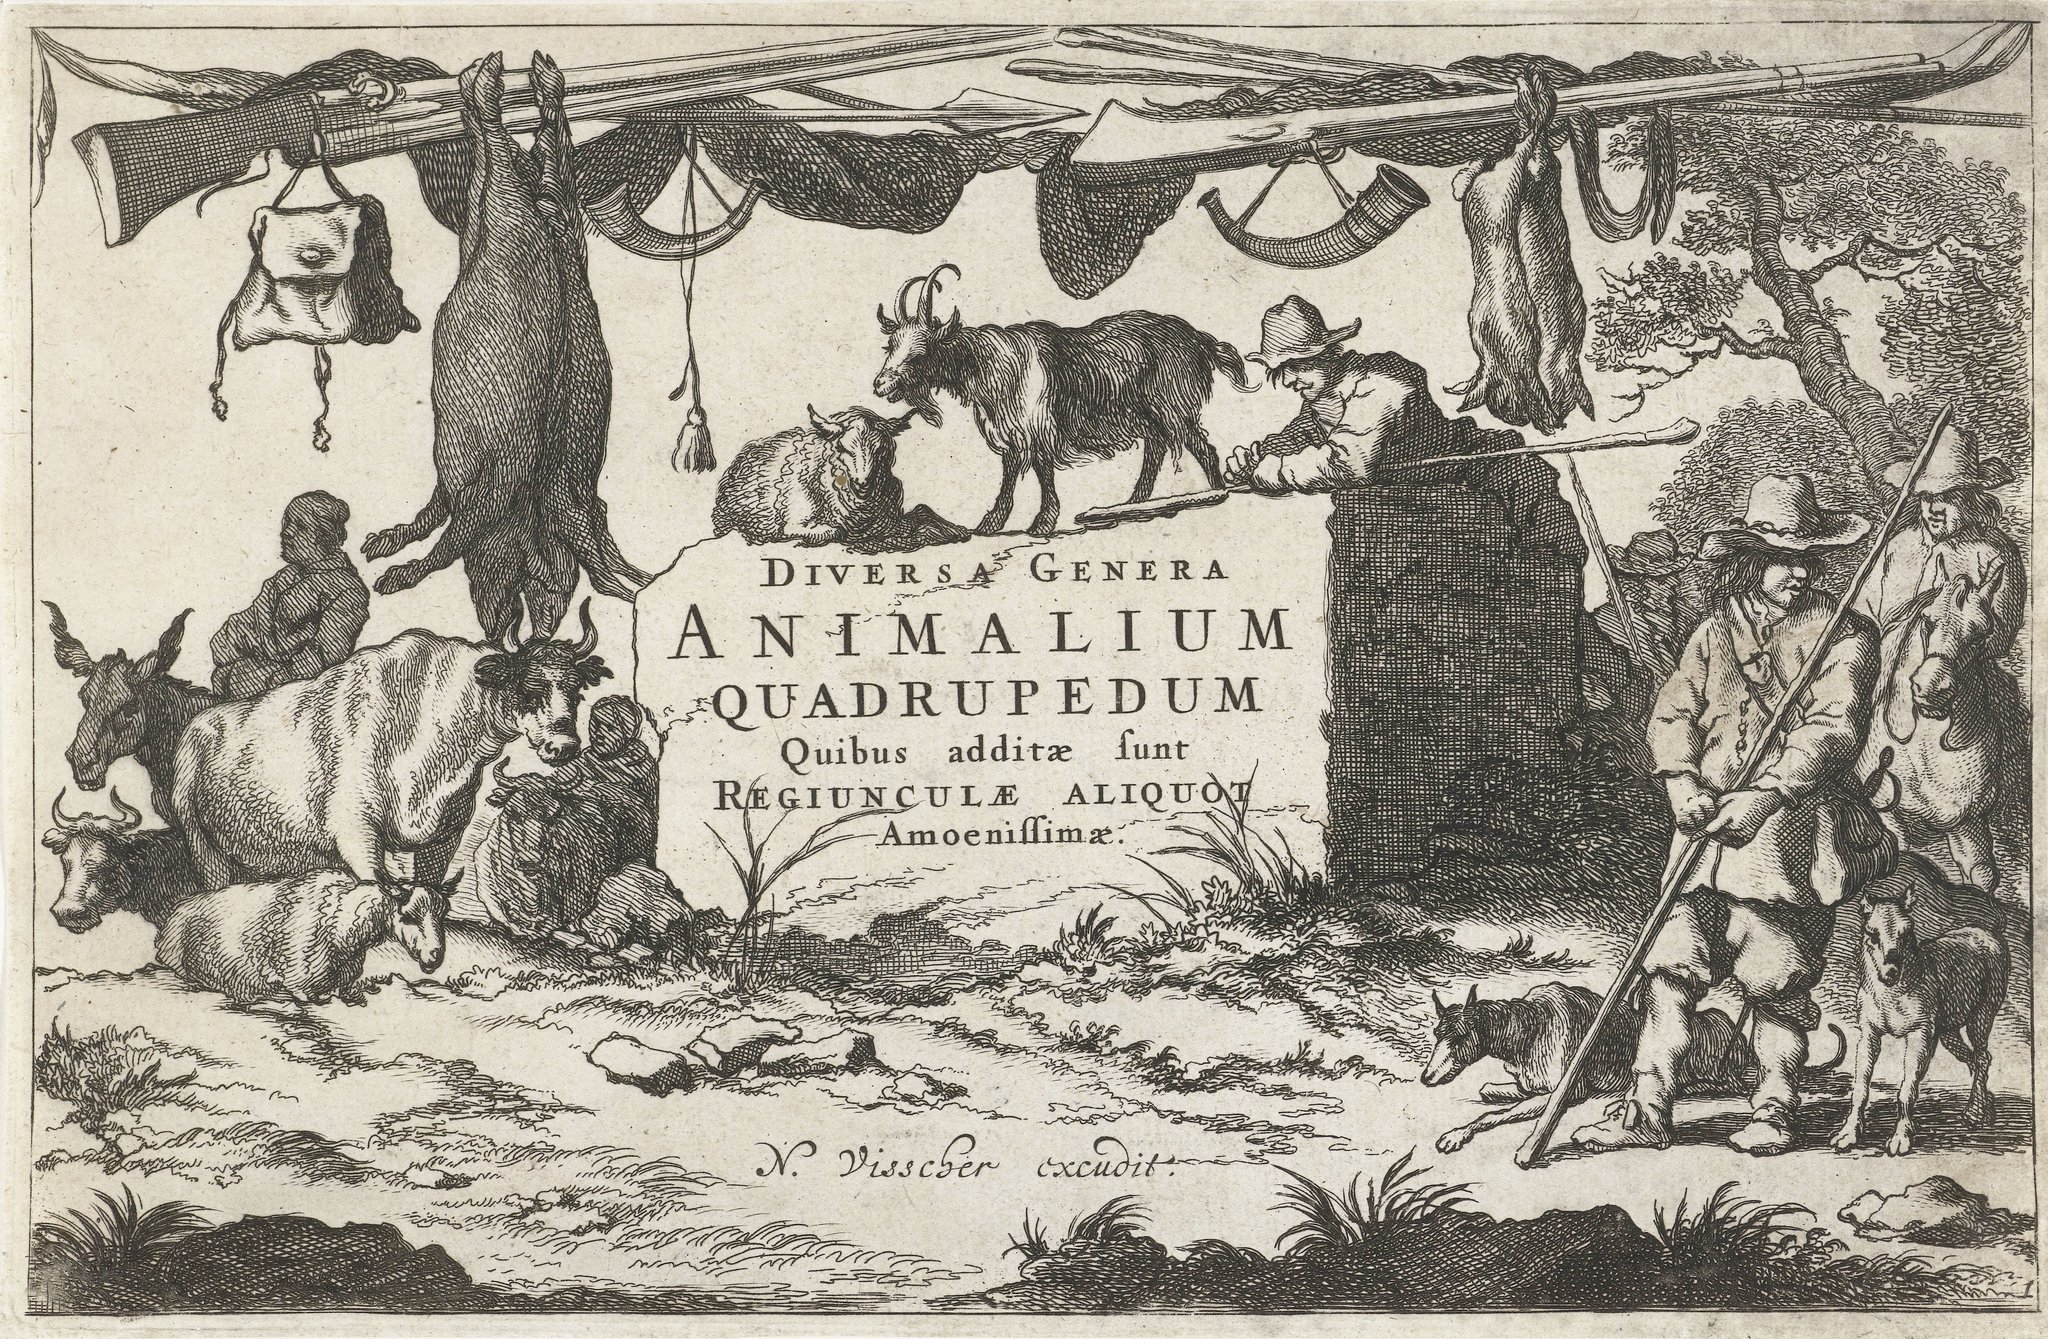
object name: titelprent, frontispice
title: Titelprent met herders en vee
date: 1628-1679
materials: paper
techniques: engraving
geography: amsterdam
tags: herding, herdsman, herdswoman, shepherd, shepherdess, cowherd, etc., title-page, firearms: rifle, hunting trophies, herd, flock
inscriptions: collector's mark: Lugt 2228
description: Centraal op een stenen blok de Latijnse titel van de serie en de naam van de uitgever. Rondom de titel staan herders met koeien, schapen en geiten. Bovenaan de prent enkele jachtwapens en geschoten wild als ornamenten. Deze prent is de titelprent van een serie over vierpotige dieren.